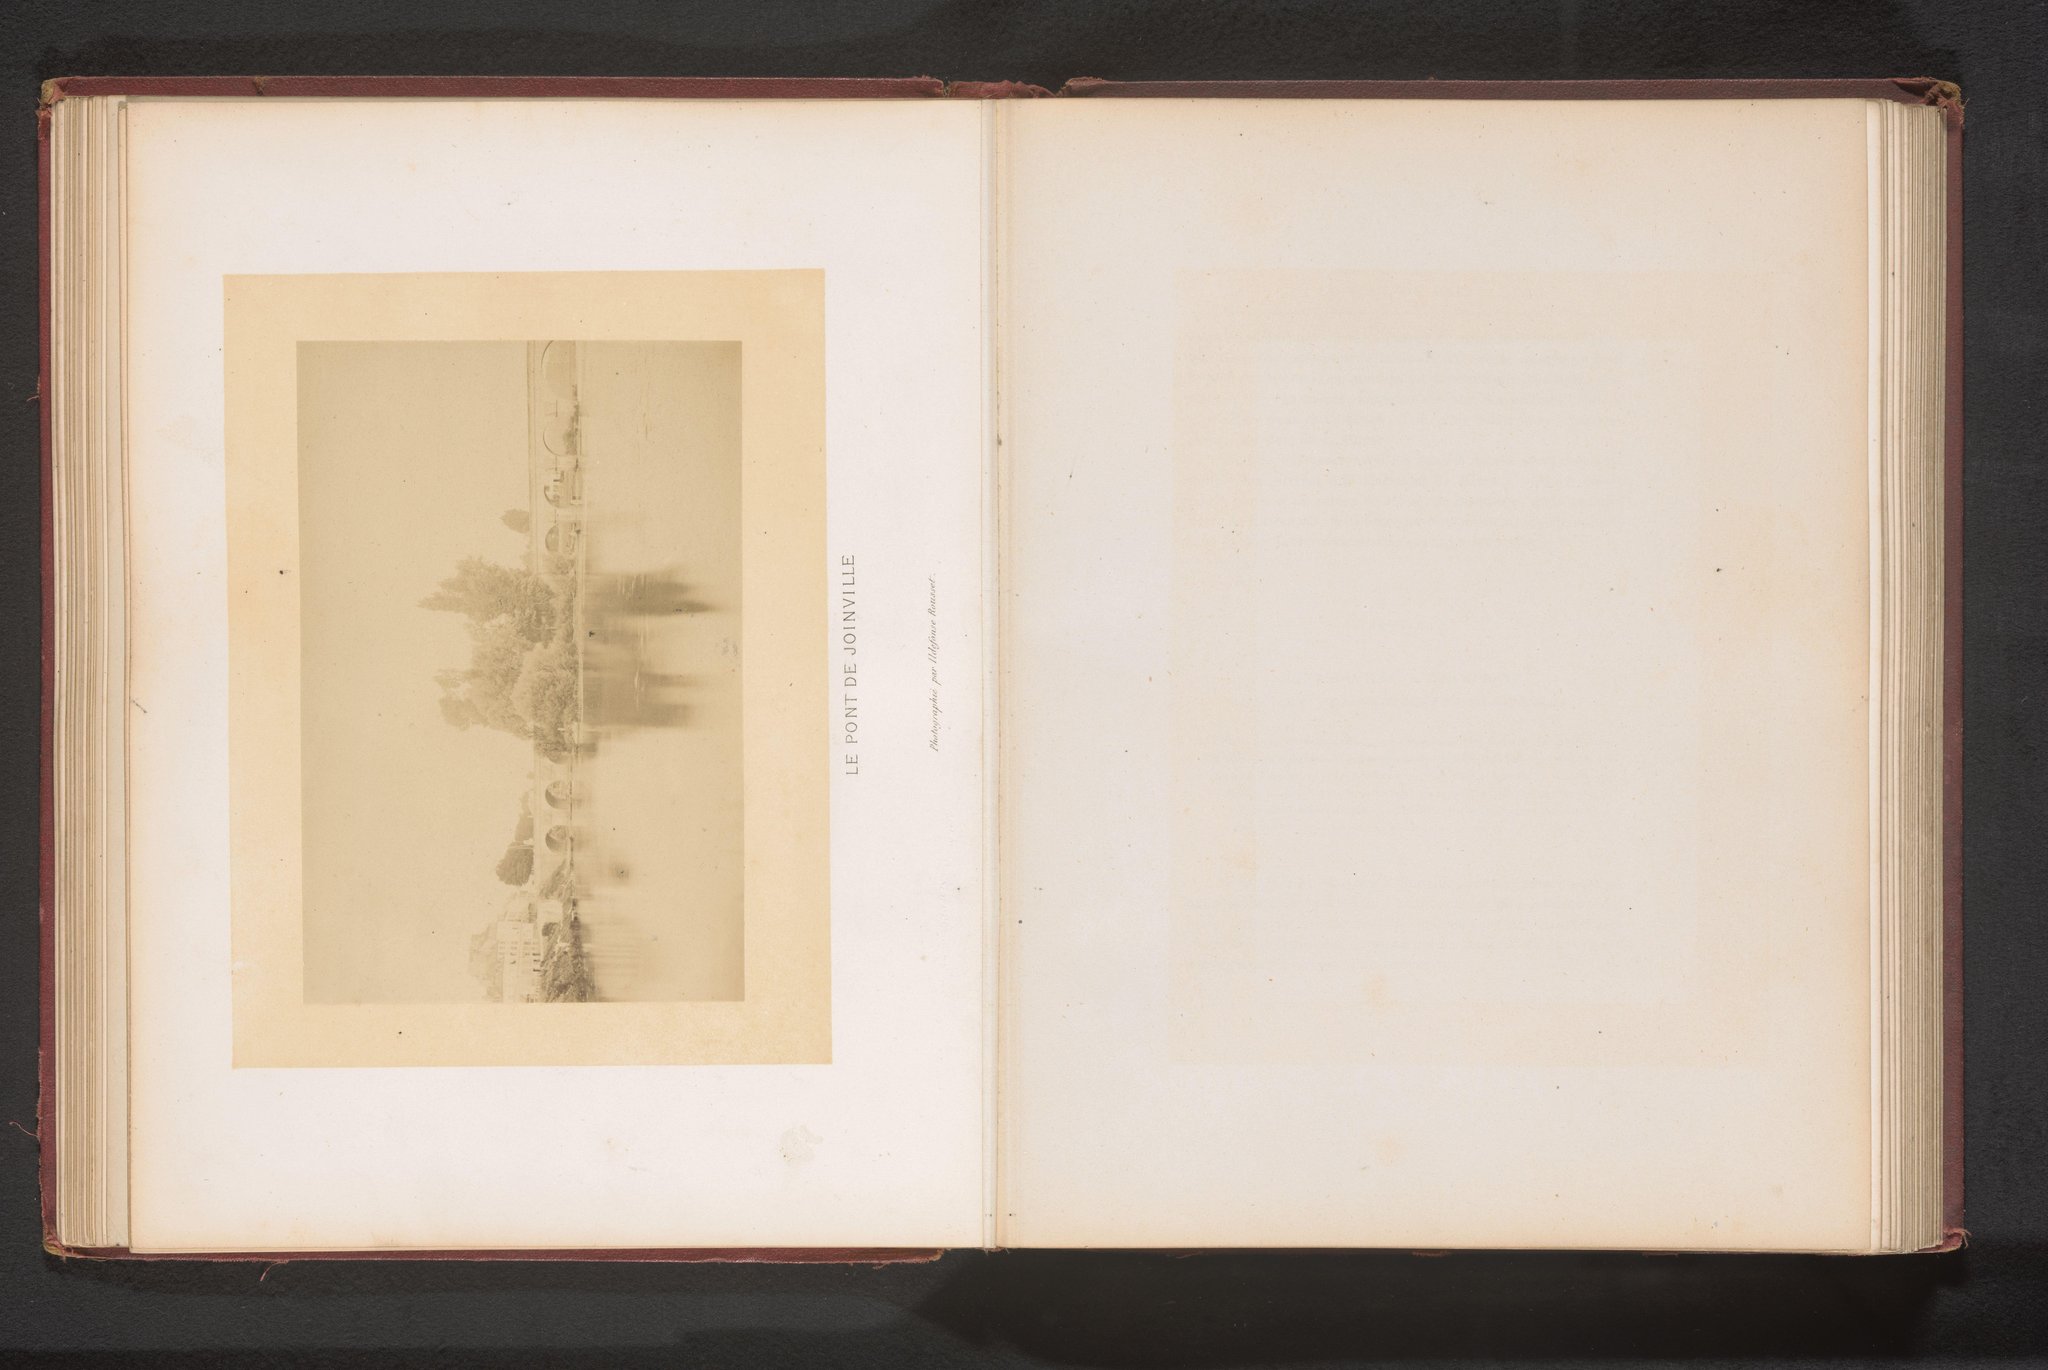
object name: page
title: Gezicht op de Pont de Joinville te Joinville-le-Pont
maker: ildefonse rousset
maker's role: fotograaf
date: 1860-1865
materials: photographic support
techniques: albumen print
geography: ile-de-france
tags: city-view in general; 'veduta', river, landscape with bridge, viaduct or aqueduct